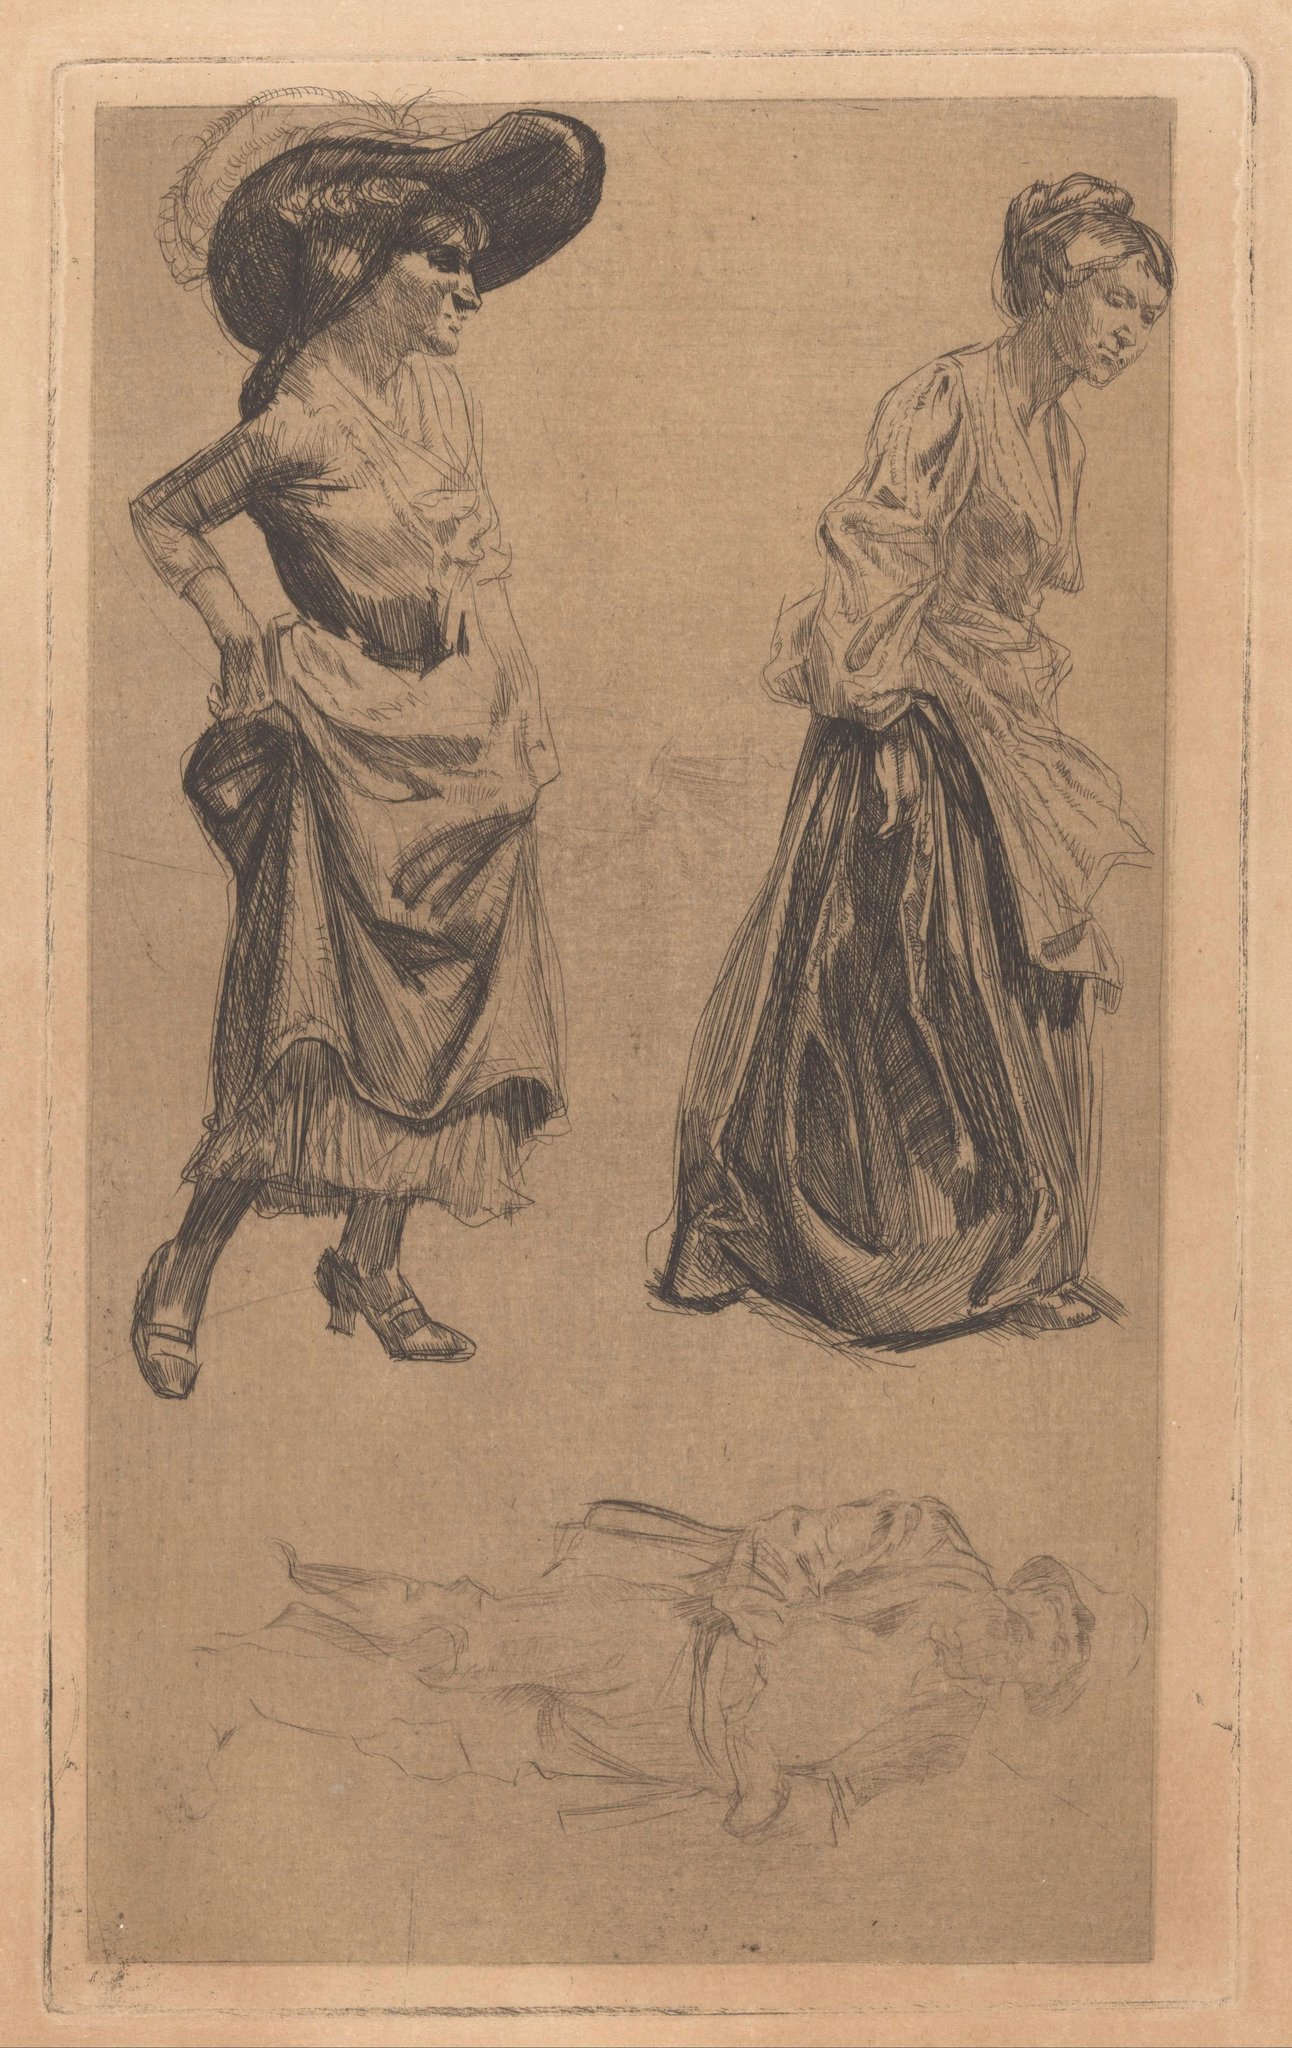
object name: print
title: Studieblad met vrouwenfiguren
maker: johannes josephus aarts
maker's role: draughtsman, print maker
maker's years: 1871-1934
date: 1912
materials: paper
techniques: etching, intaglio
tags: standing figure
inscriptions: collector's mark: Lugt 2228, collector's mark: Lugt 2760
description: Twee vrouwenfiguren, waarvan een in profiel naar rechts en een driekwart naar rechts. Verder een mannenfiguur, van voren.